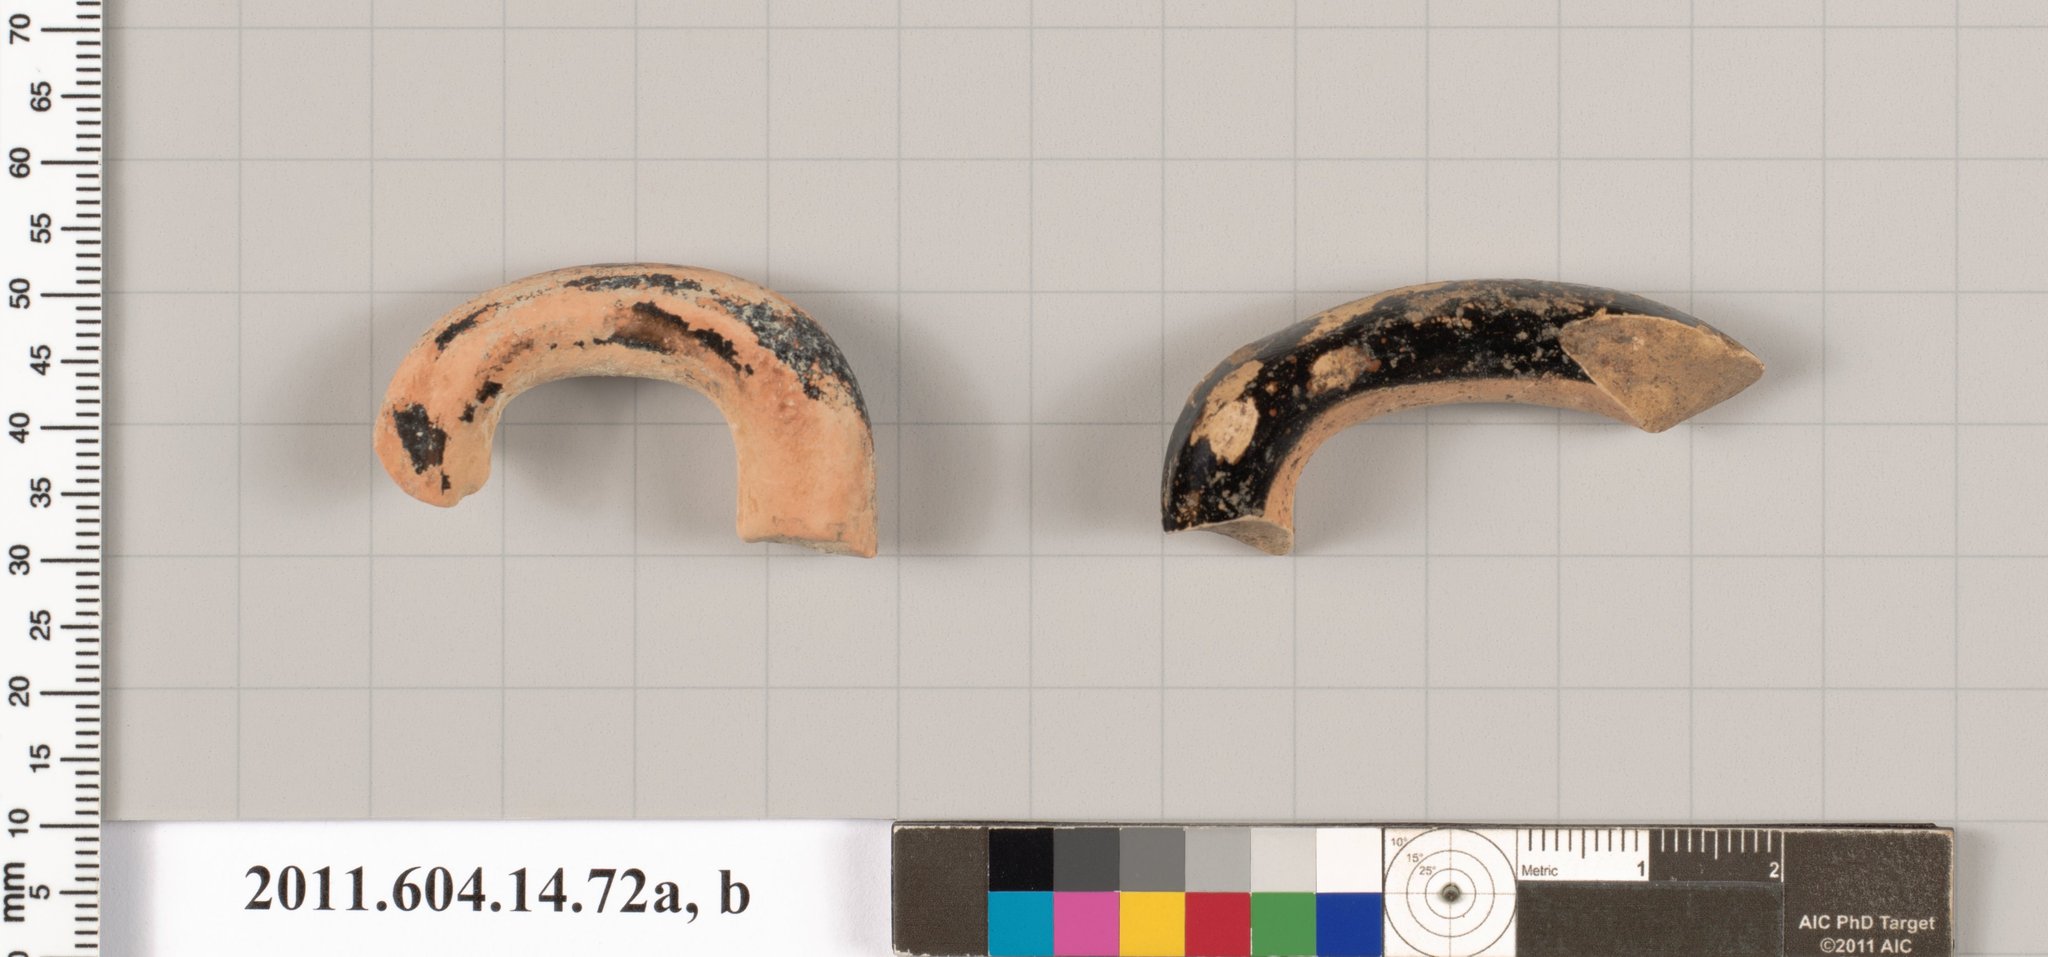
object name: kylix fragment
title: Terracotta fragments of kylikes (drinking cups)?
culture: unknown fabric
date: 600-401 BCE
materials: terracotta